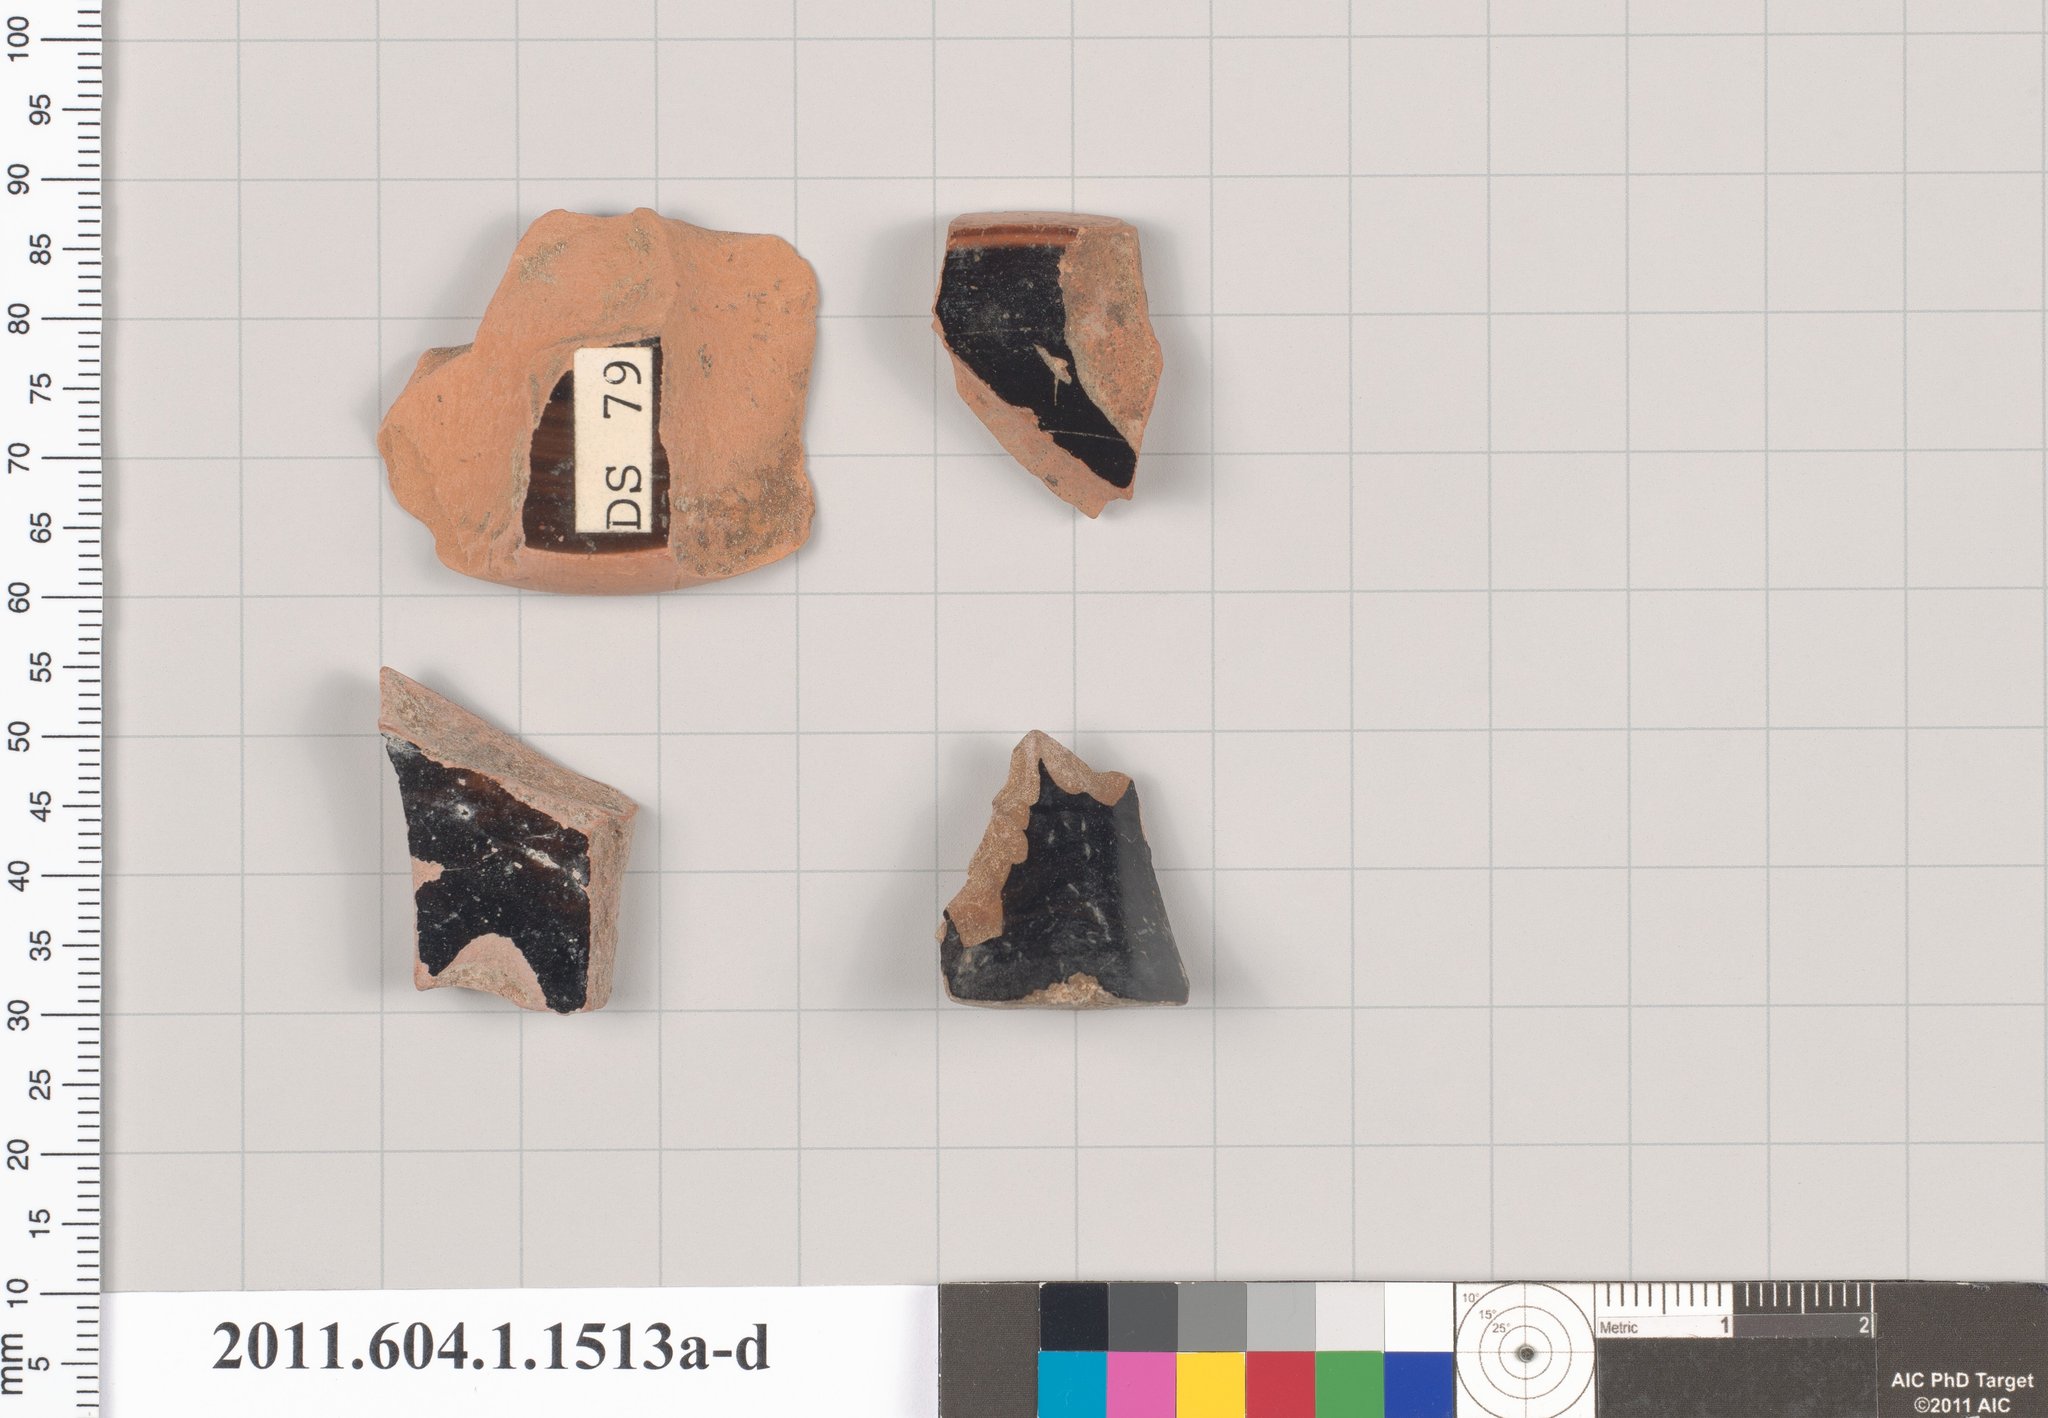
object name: kylix fragment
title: Terracotta fragments of kylikes (drinking cups)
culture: greek, attic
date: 500-401 BCE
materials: terracotta